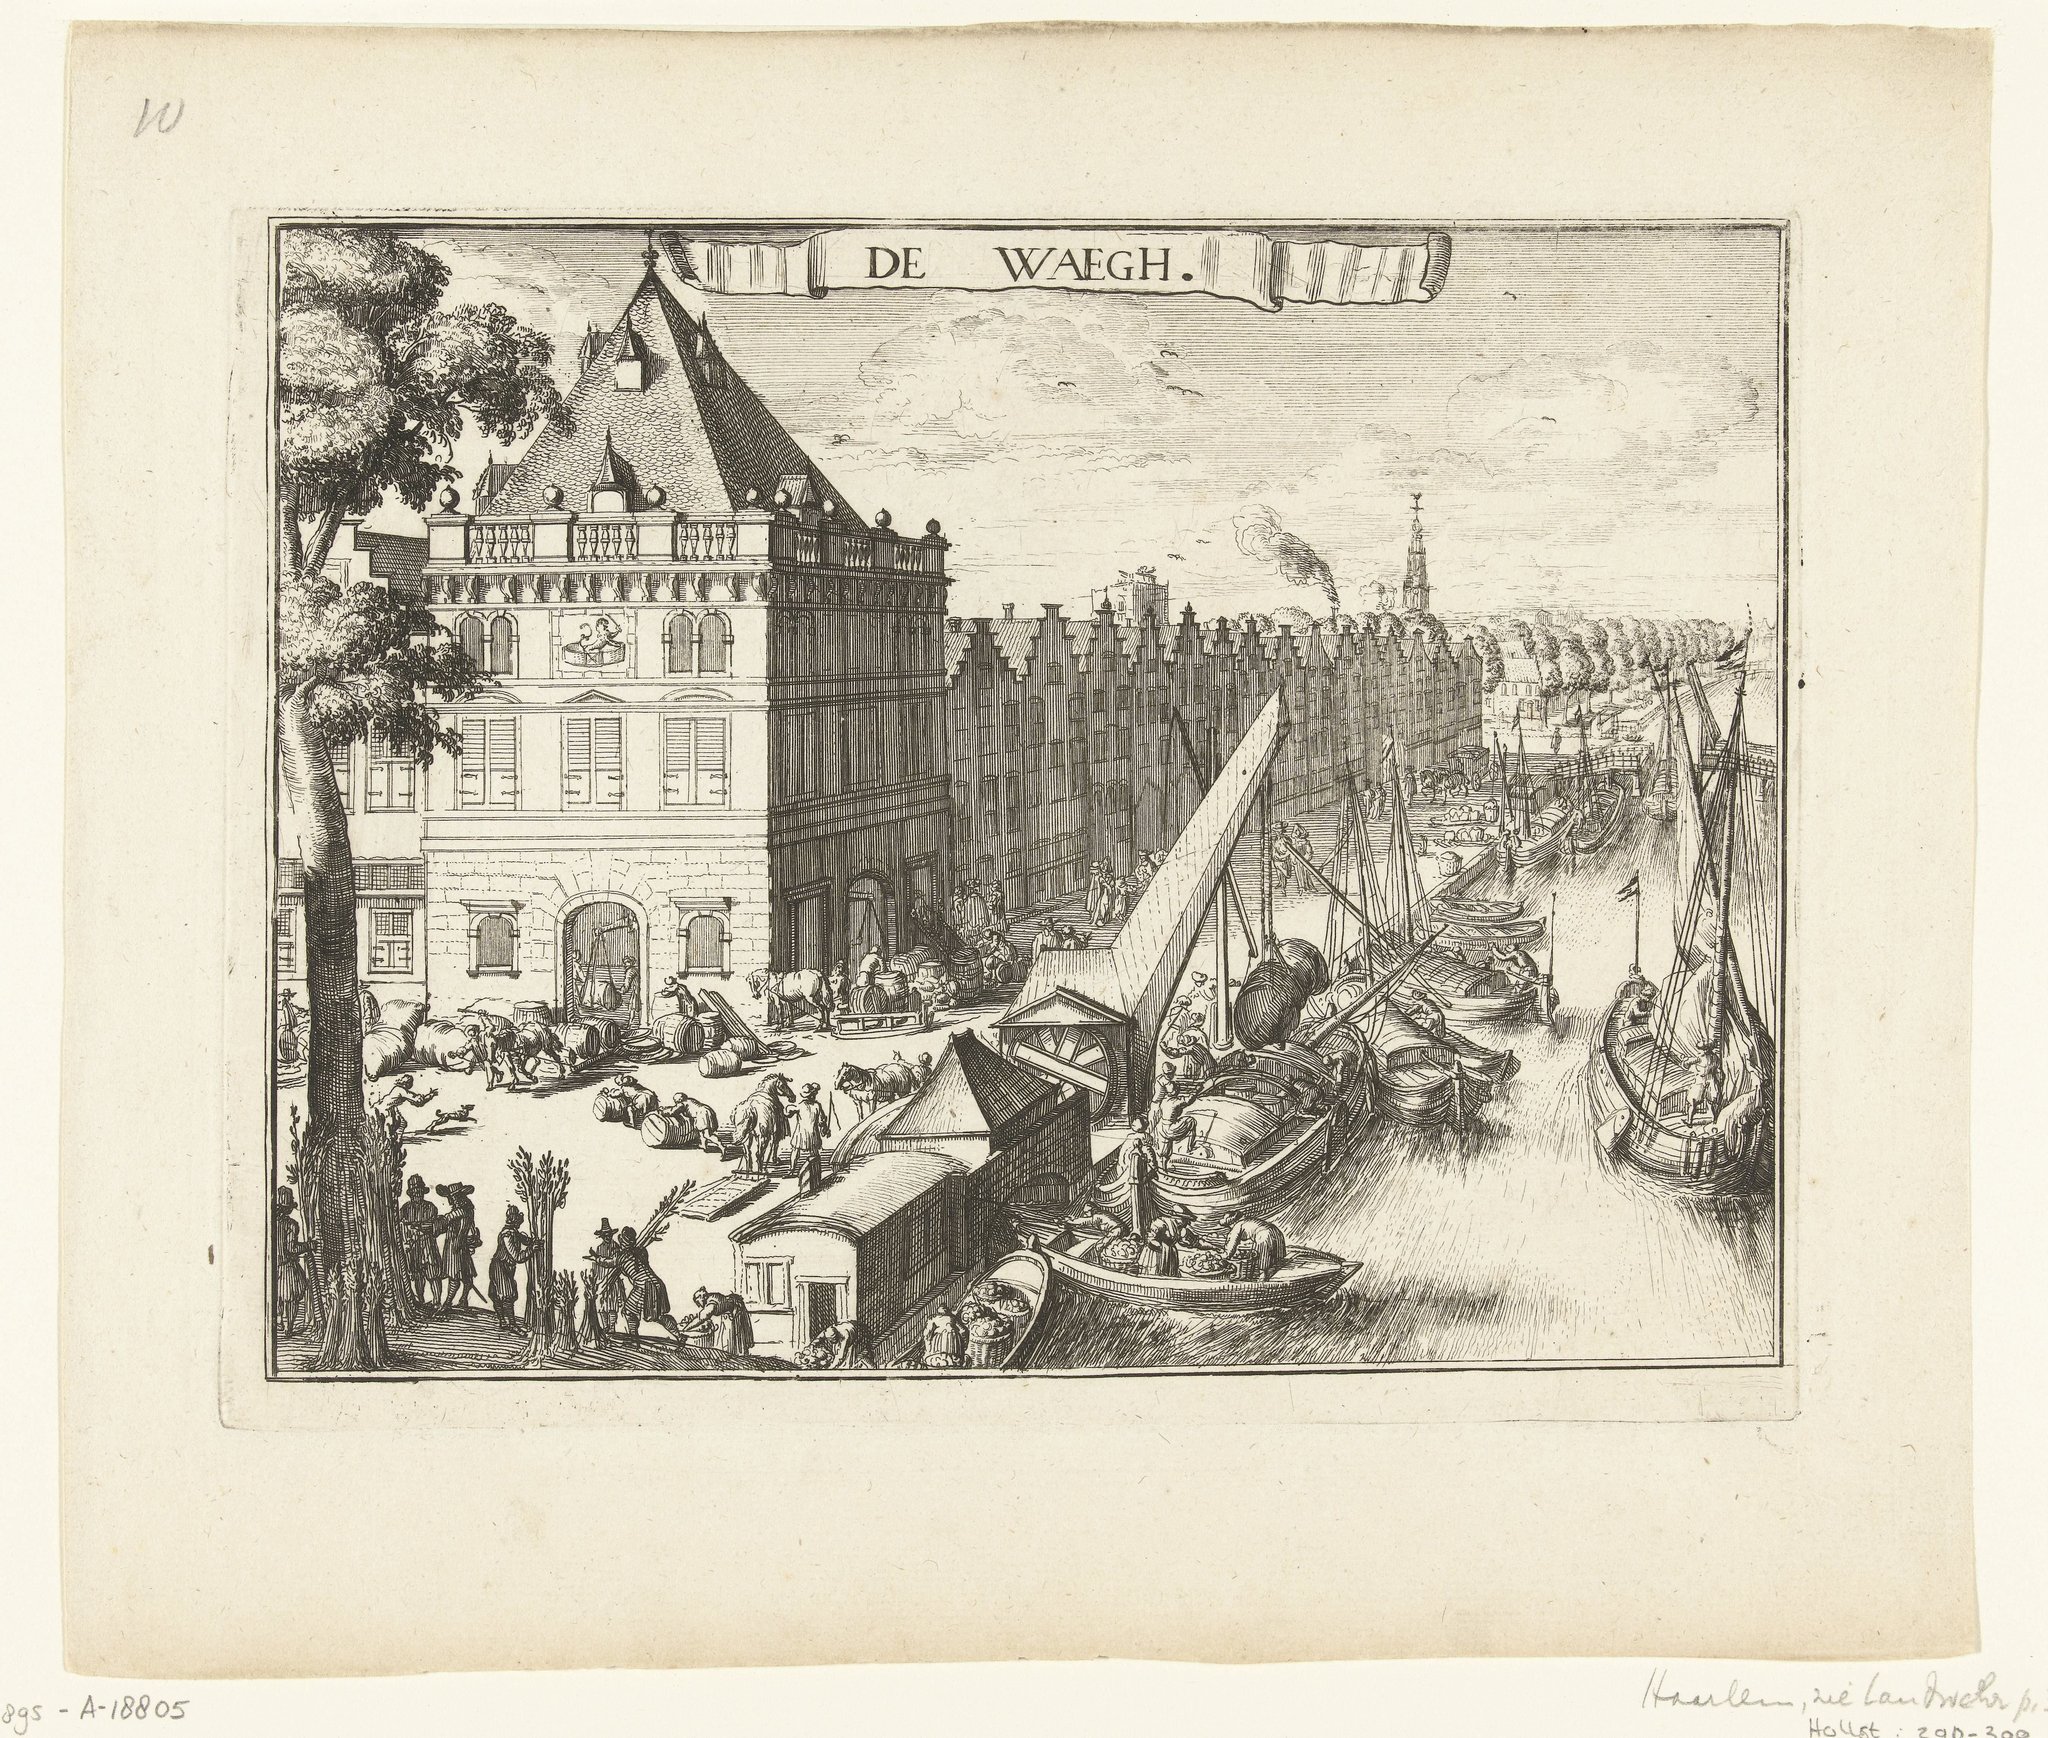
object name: print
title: Gezicht op de Waag te Haarlem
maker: romeyn de hooghe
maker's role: draughtsman, goldsmith, painter, print maker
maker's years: 1645-1708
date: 1688-1689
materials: paper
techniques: etching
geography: haarlem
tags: weigh-house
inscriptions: collector's mark: Lugt 2228a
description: Gezicht op de Waag te Haarlem aan het Spaarne, met vele handelaars die hun koopwaren per boot of ton erheen brengen. Dit blad maakt deel uit van een omvangrijke prent met een grote plattegrond van Haarlem, omgeven door zeven wapenschilden, een profiel van de stad, gezichten op markante Haarlemse gebouwen en voorstellingen van belangrijke momenten uit de Haarlemse geschiedenis.